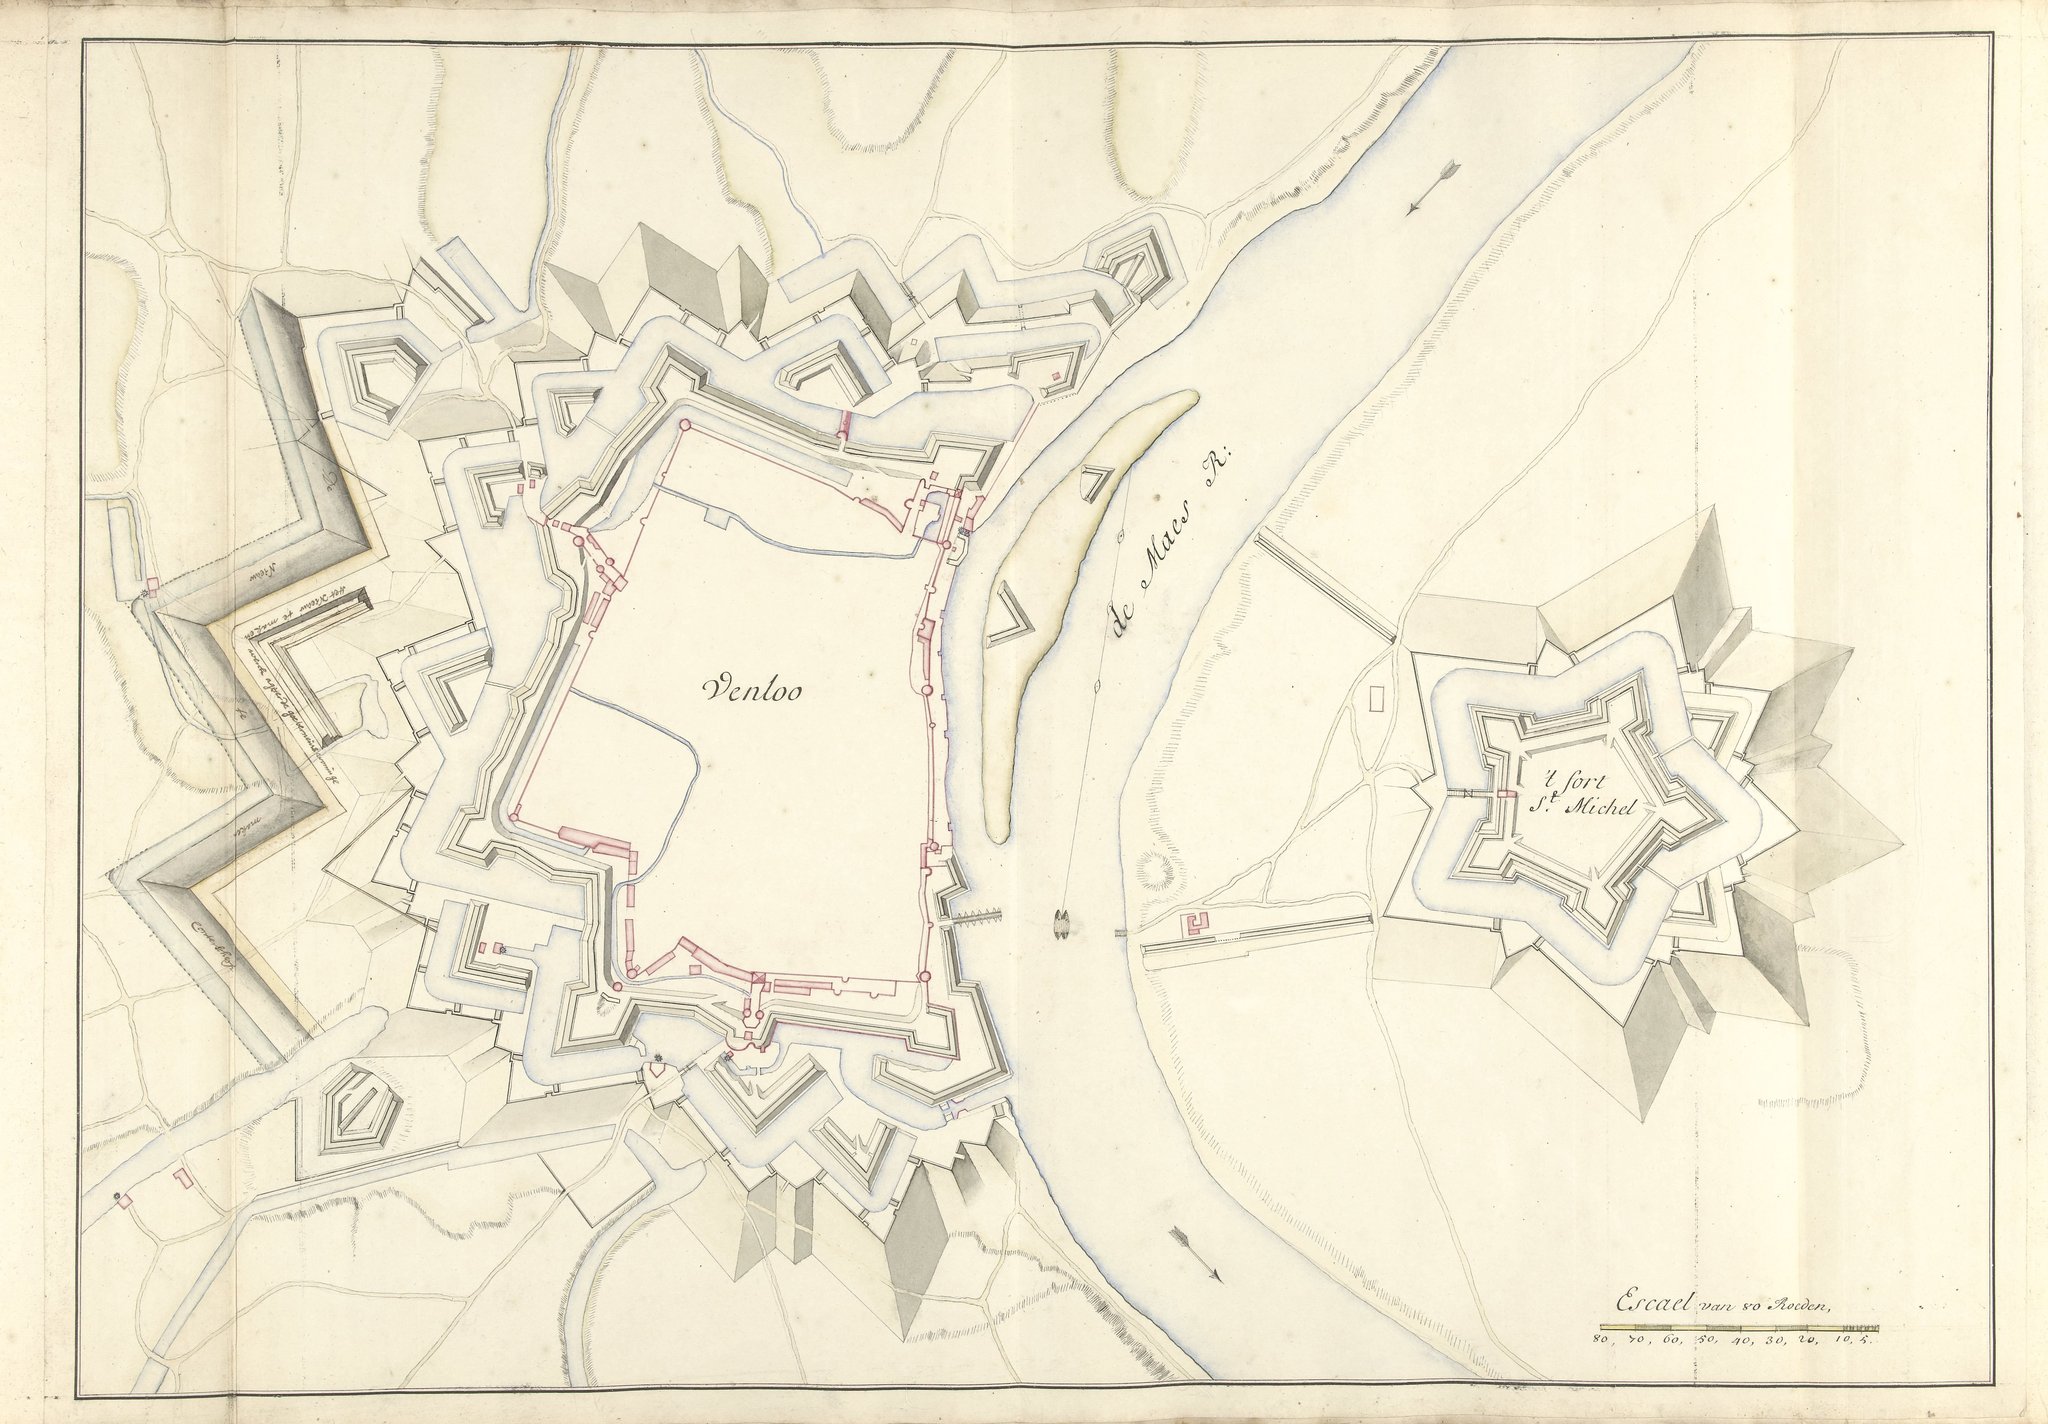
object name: map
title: Plattegrond van Venlo, ca. 1701-1715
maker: samuel du ry de champdoré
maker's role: draughtsman, engineer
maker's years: 1651-1729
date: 1701-1715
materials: paper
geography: netherlands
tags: fortress, maps of cities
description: Plattegrond van de versterkingen om de stad Venlo met het Fort Sint-Michiel, ca. 1701-1715. Onderdeel van een verzameling getekende plannen van versterkte plaatsen in Nederland en omringende landen ten tijde van de Spaanse Successieoorlog (deel B).